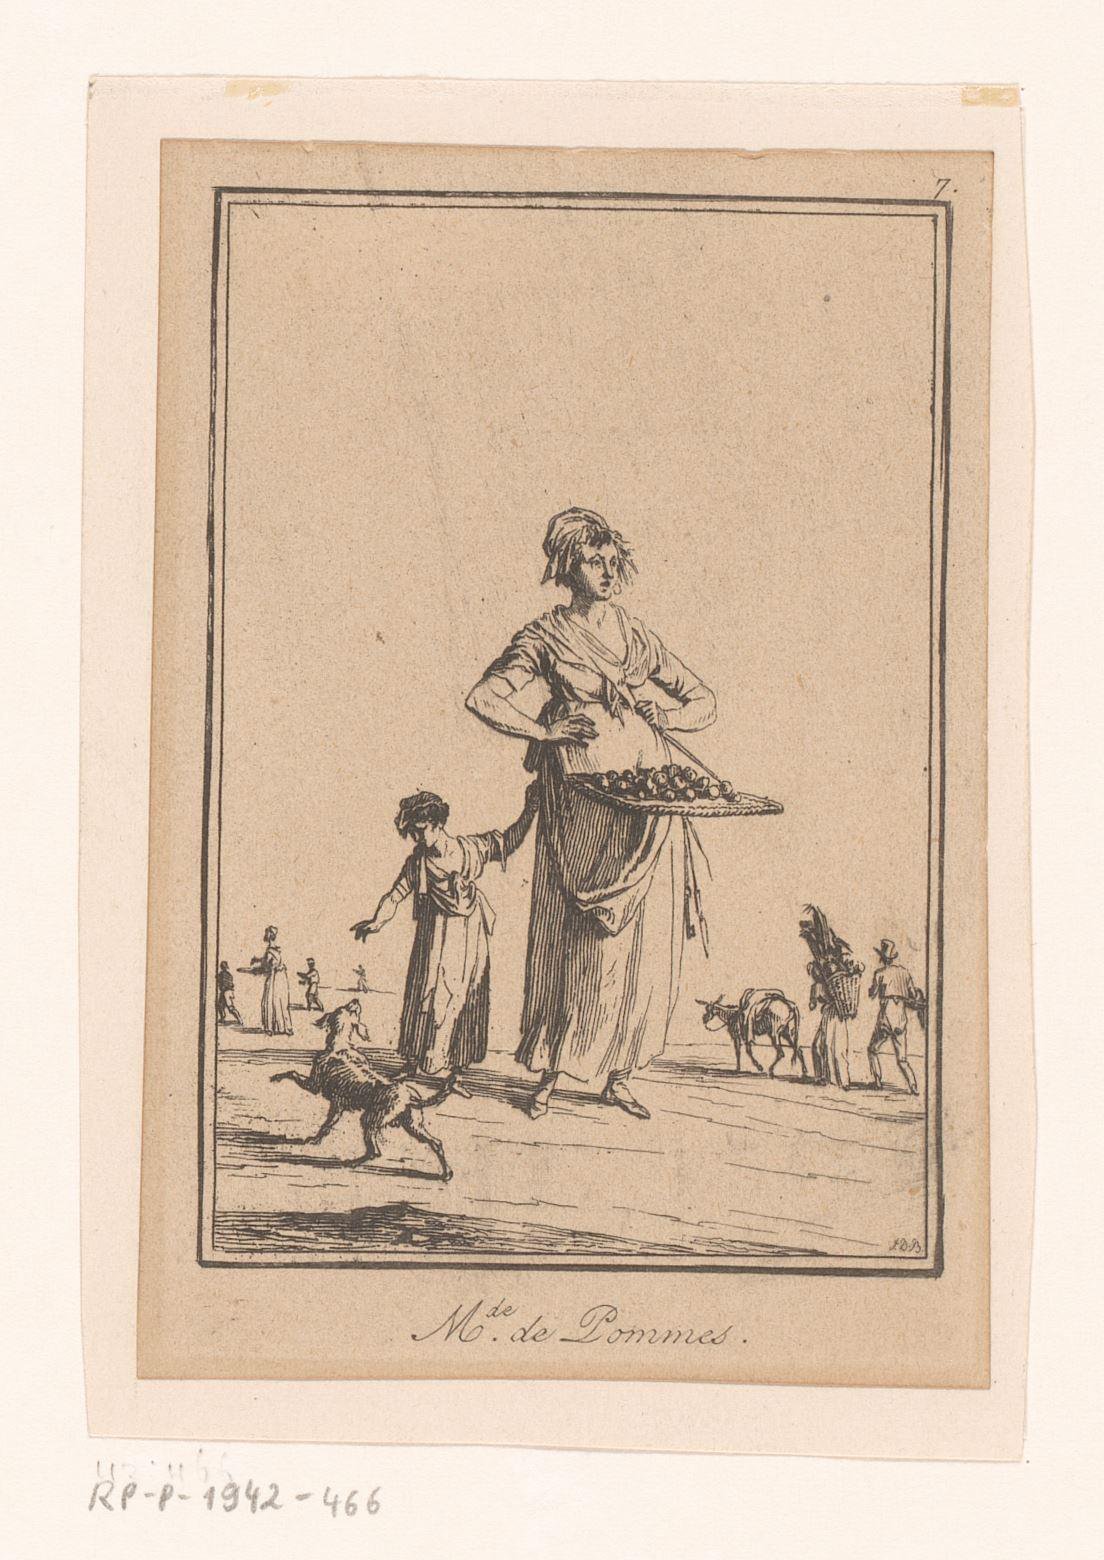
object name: print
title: Straatverkopers en dienstverleners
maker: jean duplessis-bertaux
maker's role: print maker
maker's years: 1750-1818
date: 1760-1818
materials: paper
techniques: etching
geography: france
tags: fruits: apple, 'cris de paris', cries of london, etc. - bb - women engaged in trade and commerce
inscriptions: collector's mark: Lugt 2228